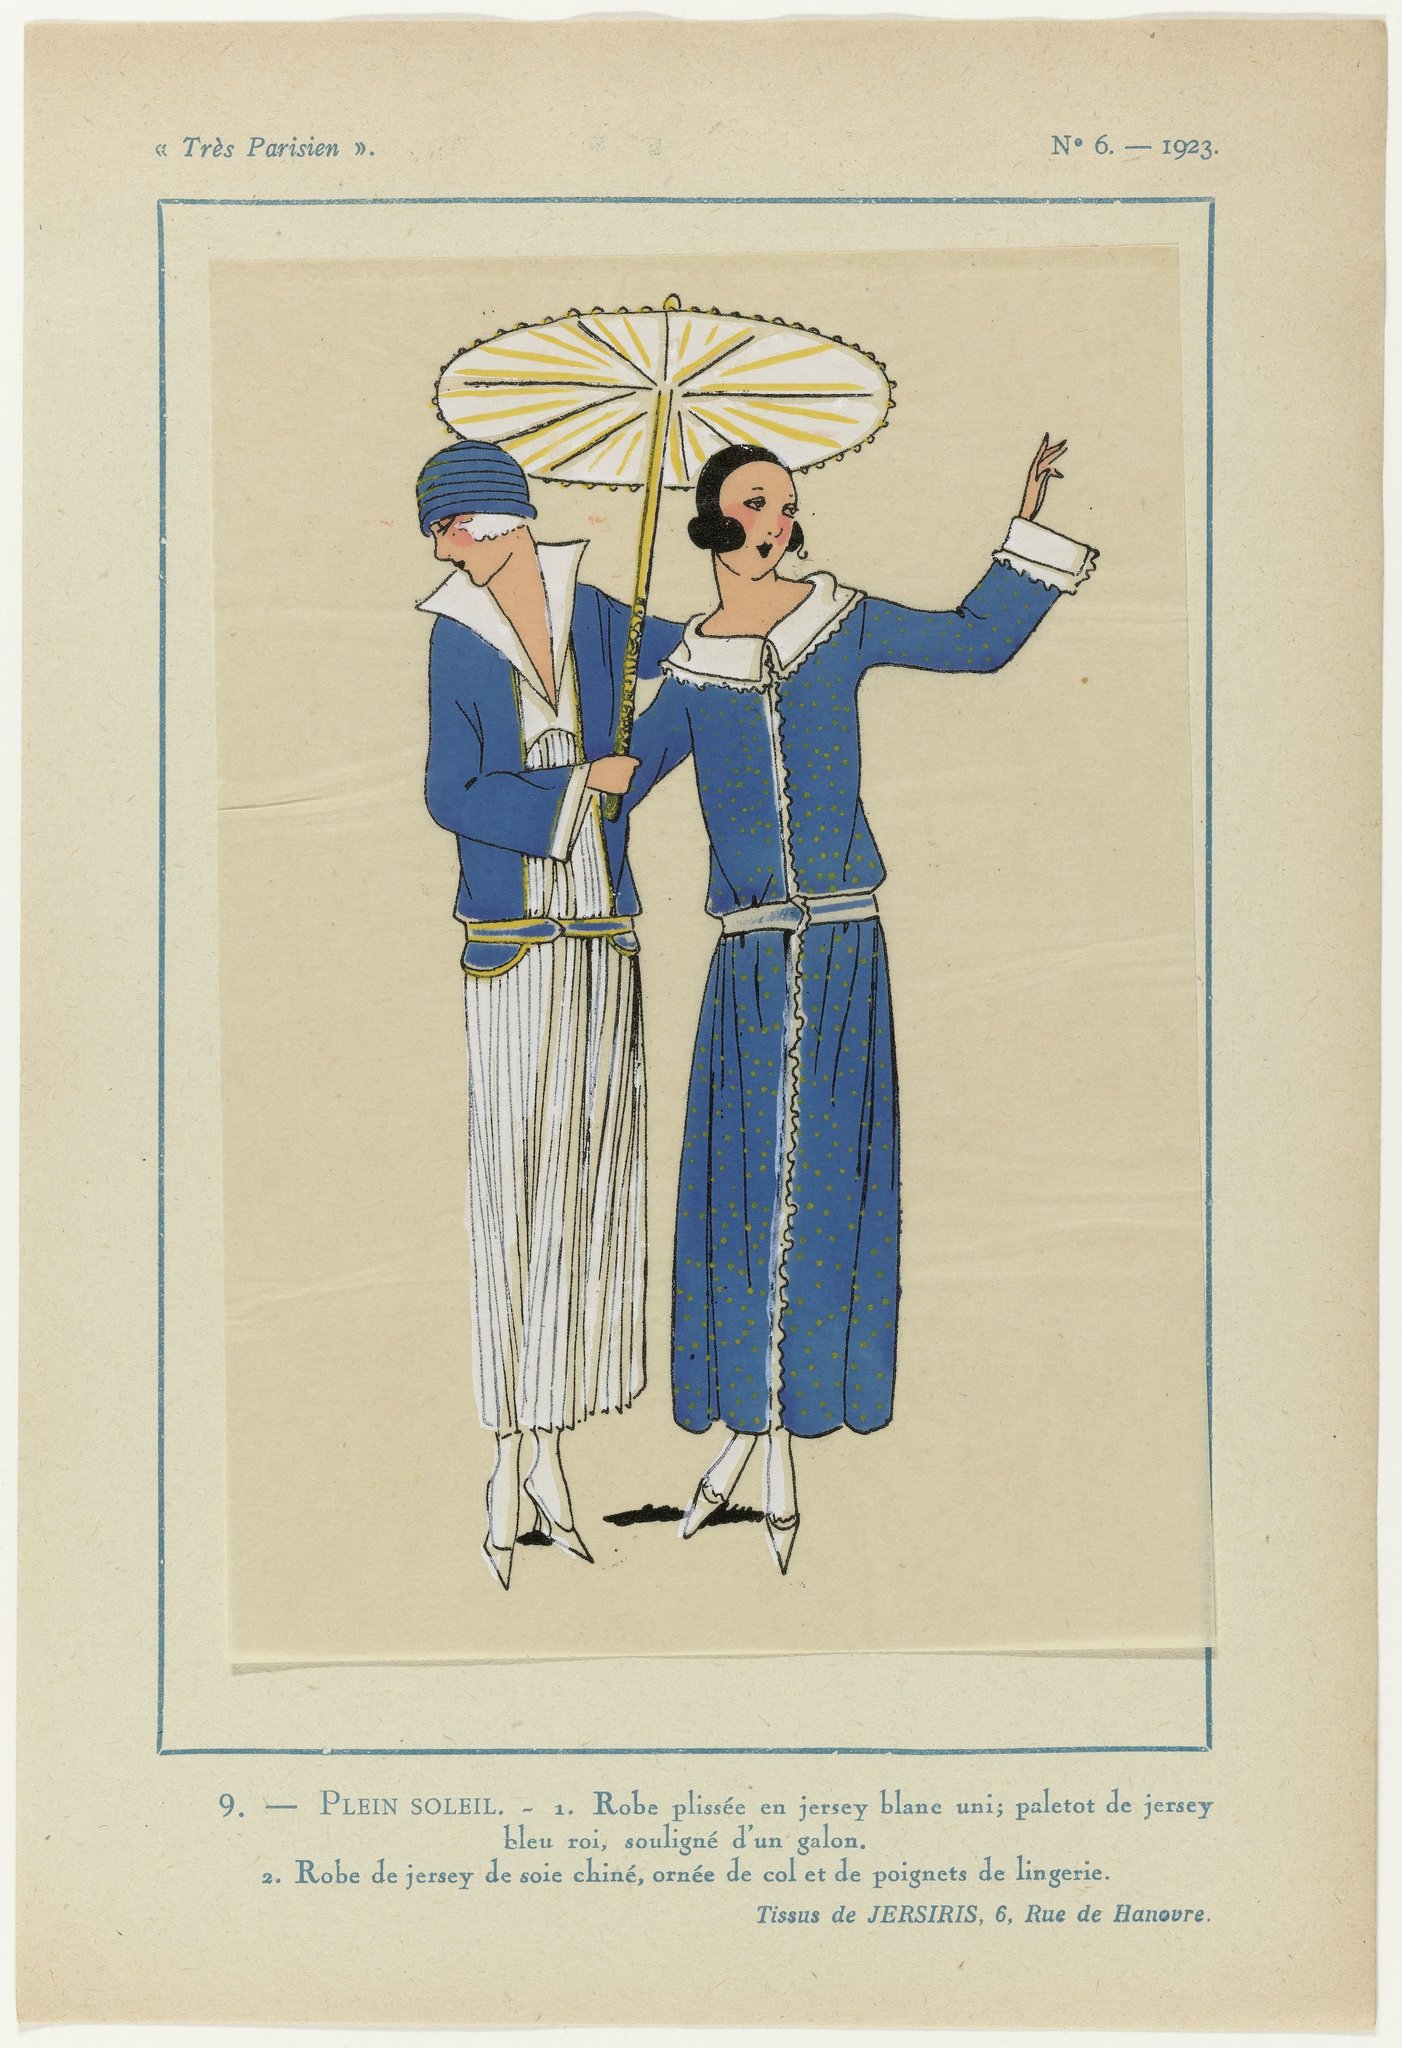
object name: fashion print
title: Très Parisien, 1923, No 6: 9.- PLEIN SOLEIL. - 1. Robe plissée en jersey blane uni...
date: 1923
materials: paper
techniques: hand coloring, letterpress printing, lithography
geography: paris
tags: coat: overcoat (+ women's clothes), neck-gear: collar (+ women's clothes), fashion plates, sleeves: cuffs (+ women's clothes), dress, gown (+ women's clothes), parasol, sunshade (+ women's clothes)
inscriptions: title: ‘Très Parisien / No 6. - 1923’, caption: ‘9. - PLEIN SOLEIL. - 1. Robe plissée en jersey blanc uni; paletot de jersey bleu roi, souligné d'un galon. 2. Robe de jersey de soie chiné, ornée de col et de poignets de lingerie. / Tissus de JERSIRIS, 6, Rue de Hanovre,’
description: 1. Geplisseerde jurk van effen witte jersey; paletot van koningsblauwe jersey versierd met een galon. 2. Jurk van jersey de soie chiné, versierd met een kraag en manchetten 'de lingerie'. Stoffen van Jersiris. Prent uit het modetijdschrift Très Parisien (1920-1936).